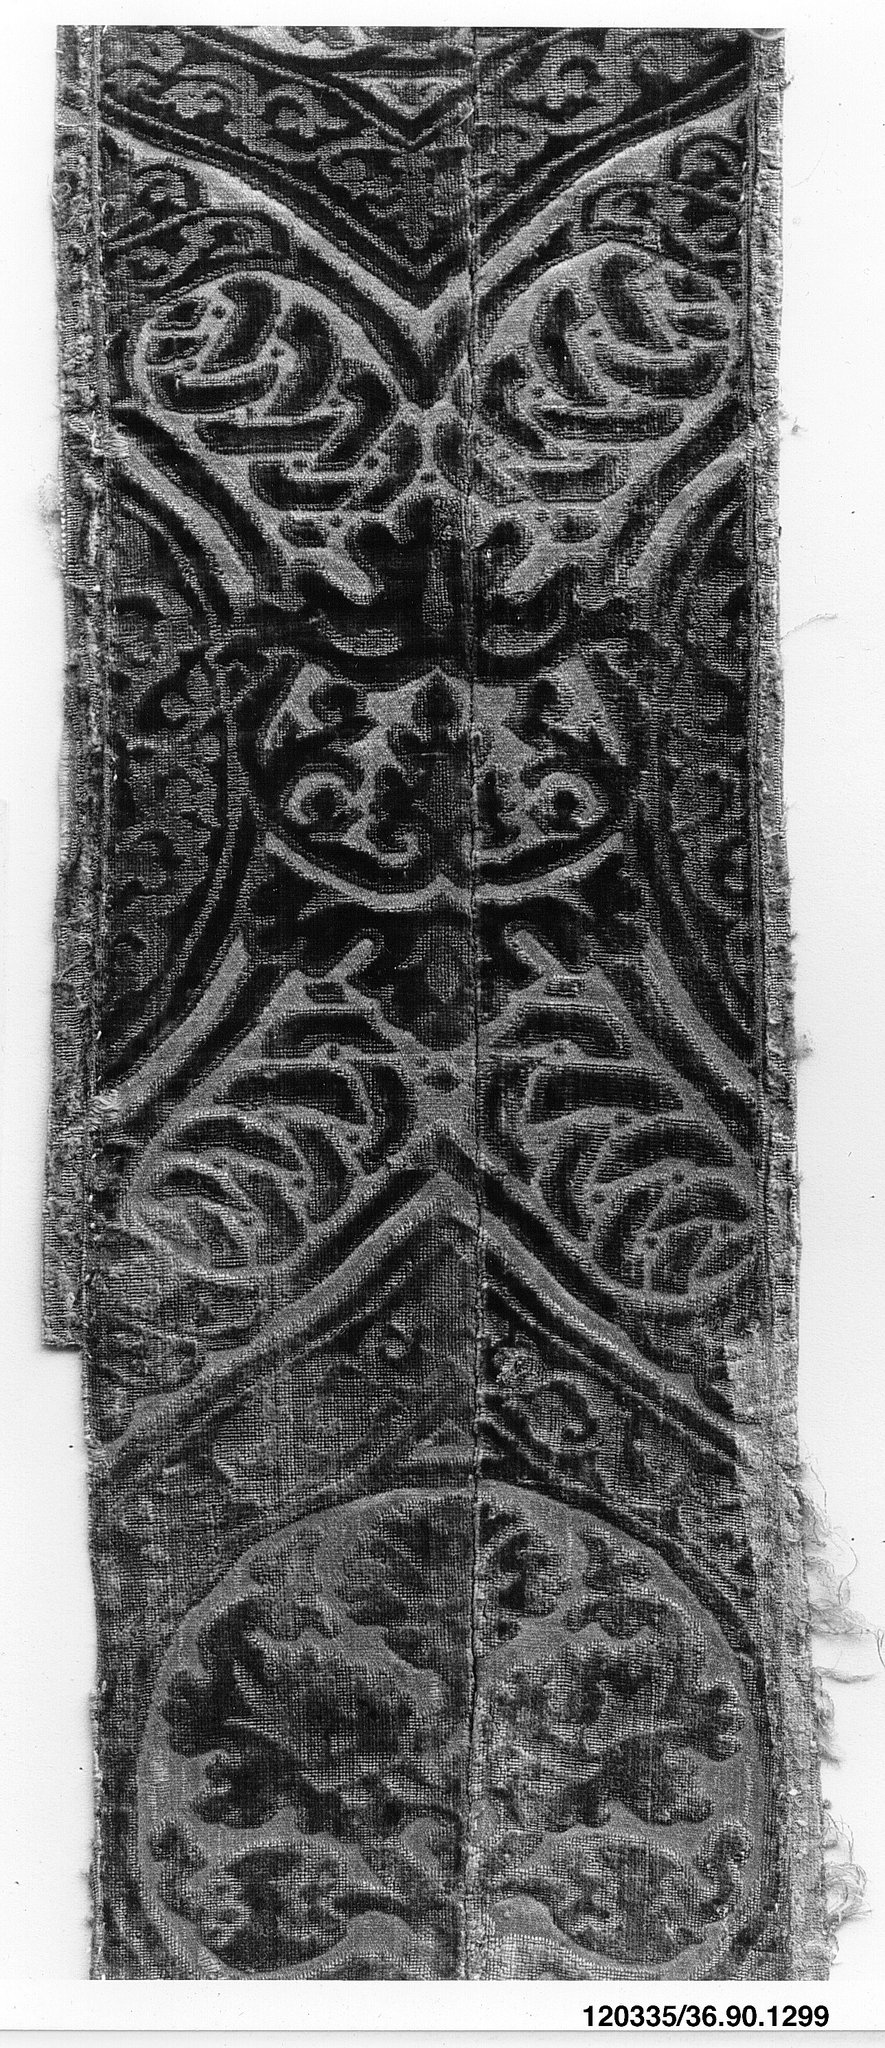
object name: piece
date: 1501-1700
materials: silk